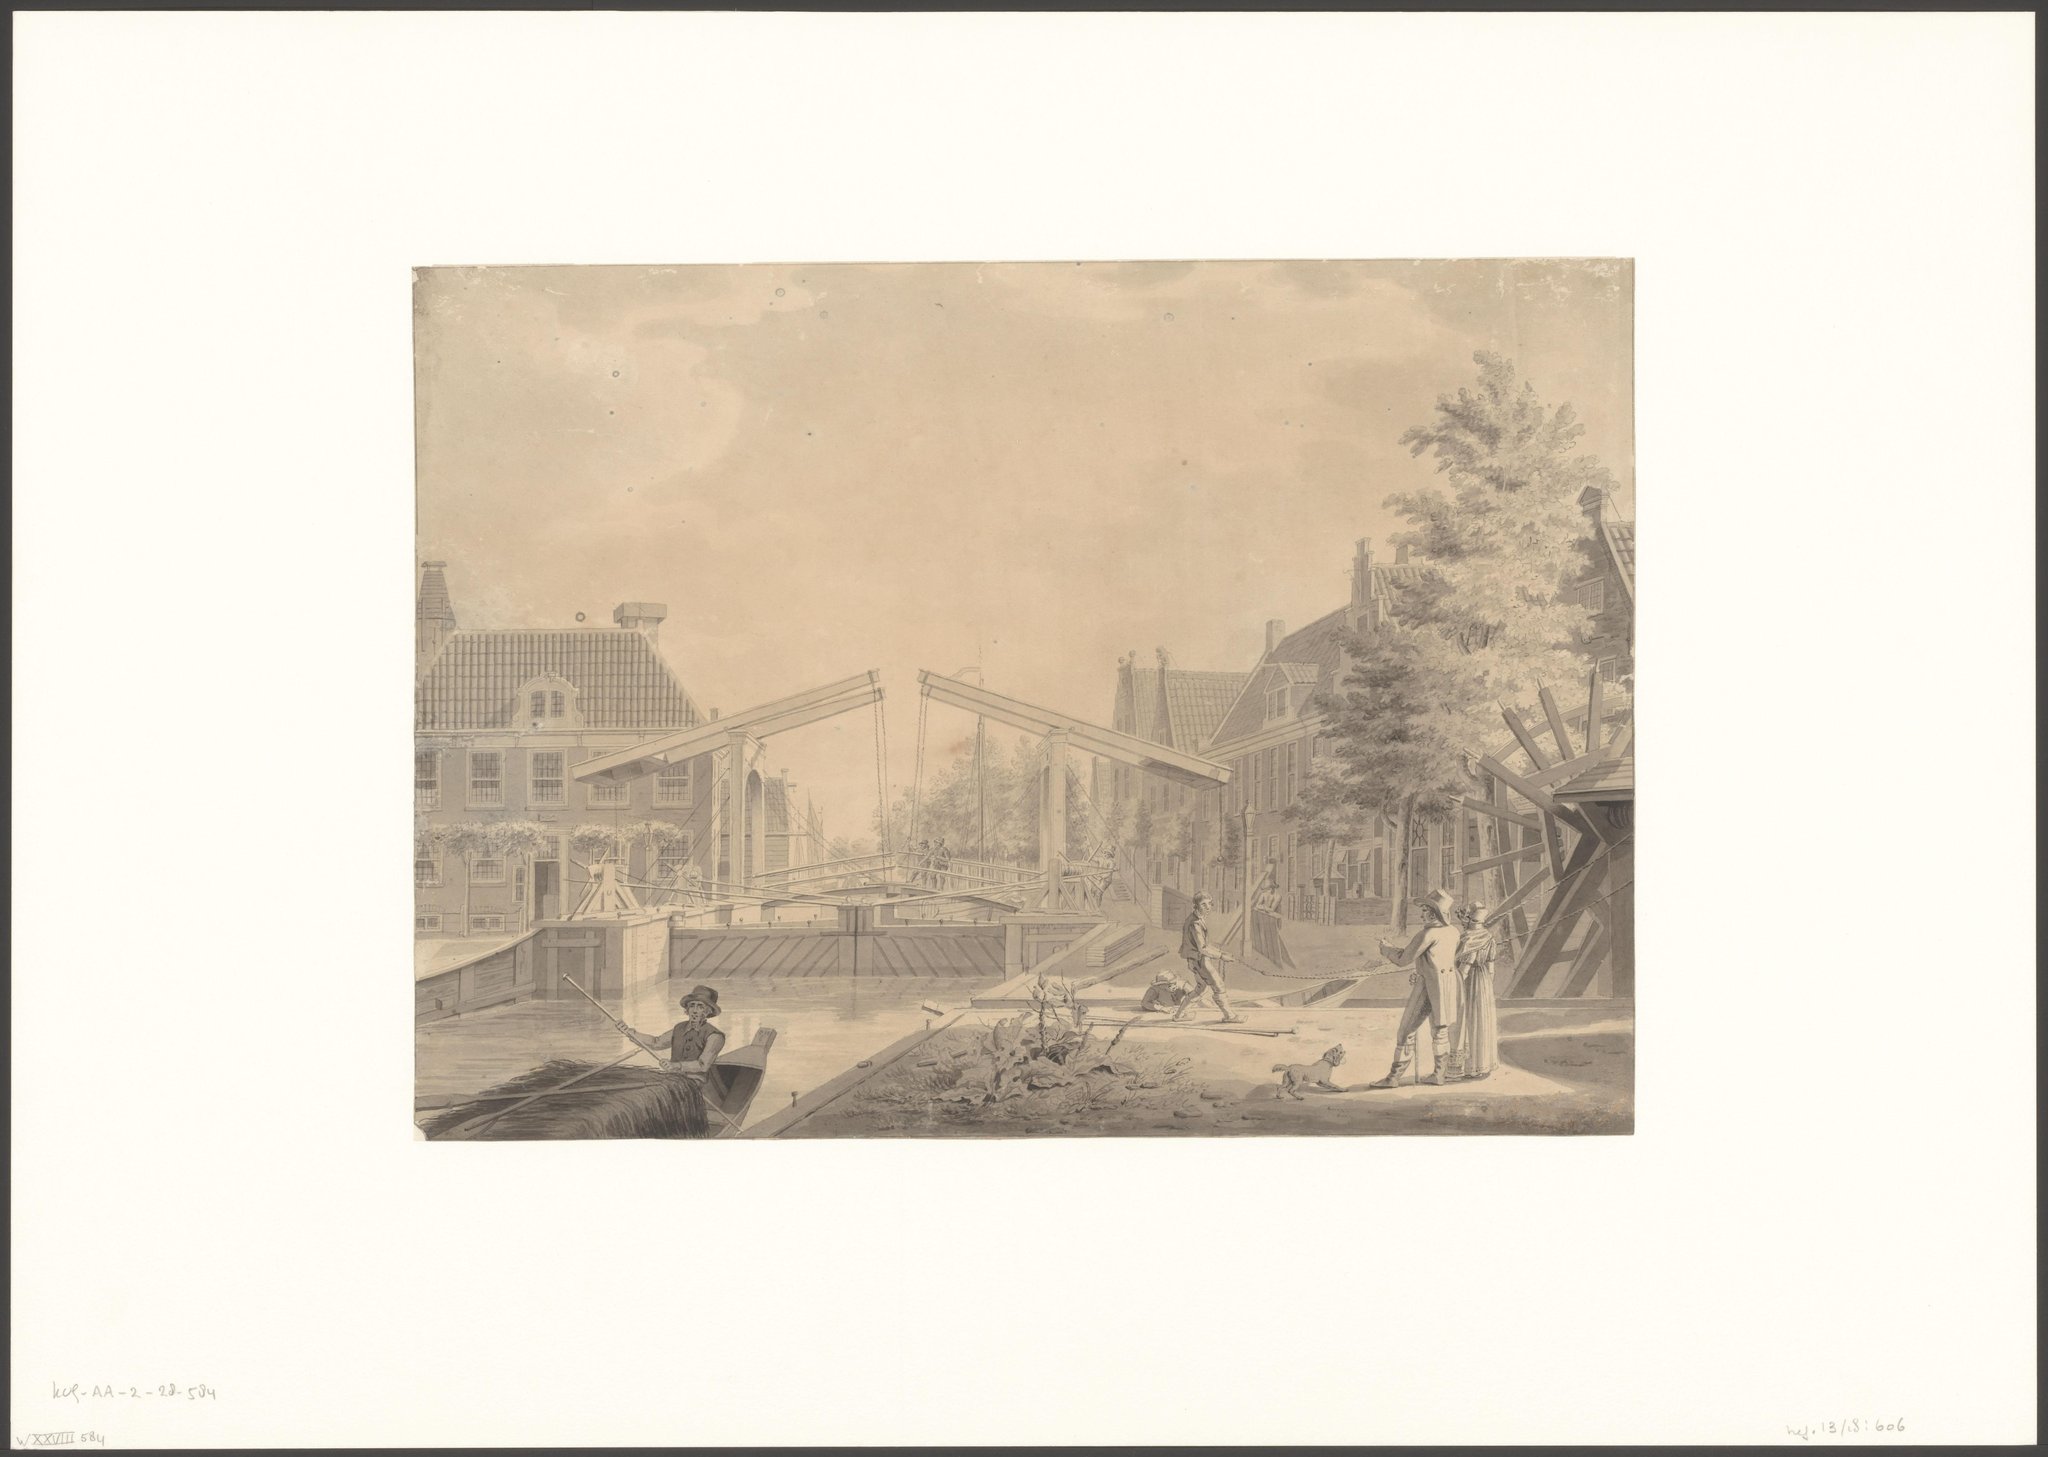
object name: drawing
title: Gezicht op de Dubbele Buurt aan het einde van de Overtoom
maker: pieter van der meulen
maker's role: draughtsman, painter, print maker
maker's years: 1780-1858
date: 1810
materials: ink, paper, pencil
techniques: brush, pen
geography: amsterdam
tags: city-view in general; 'veduta', canal, bridge in city across river, canal, etc., boat propelled by man or animal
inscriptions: inscription: ‘Gezigt op de (...) Baarsjesweg te zien’, signature and date: ‘P.H.L.v.d. Meulen Fecit 1810’, collector's mark: Lugt 800a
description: Tekening binnen de Atlas Van Eck ingedeeld op wijknummer 28.